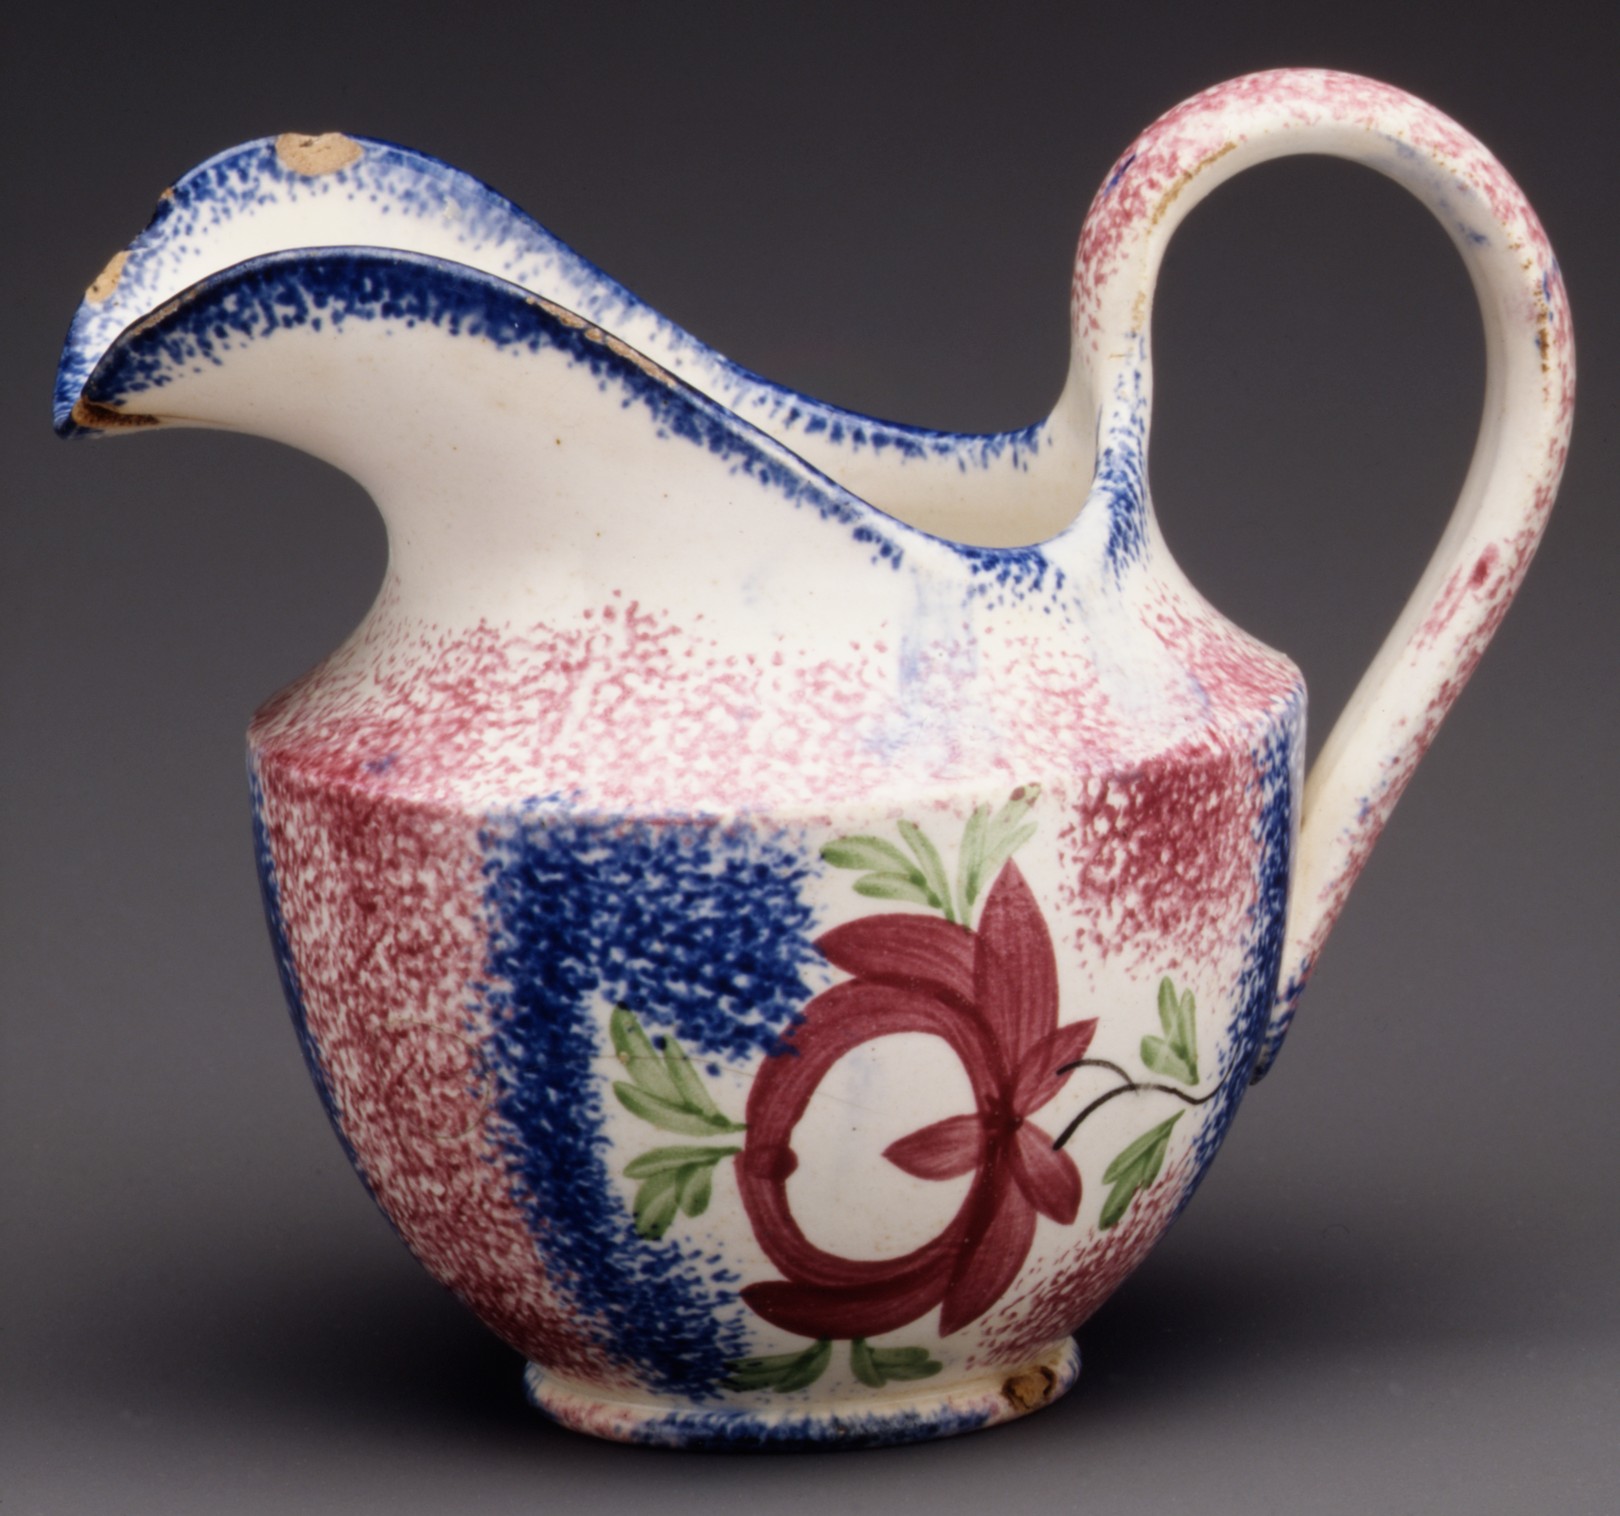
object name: pitcher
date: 1800-1830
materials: earthenware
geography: england